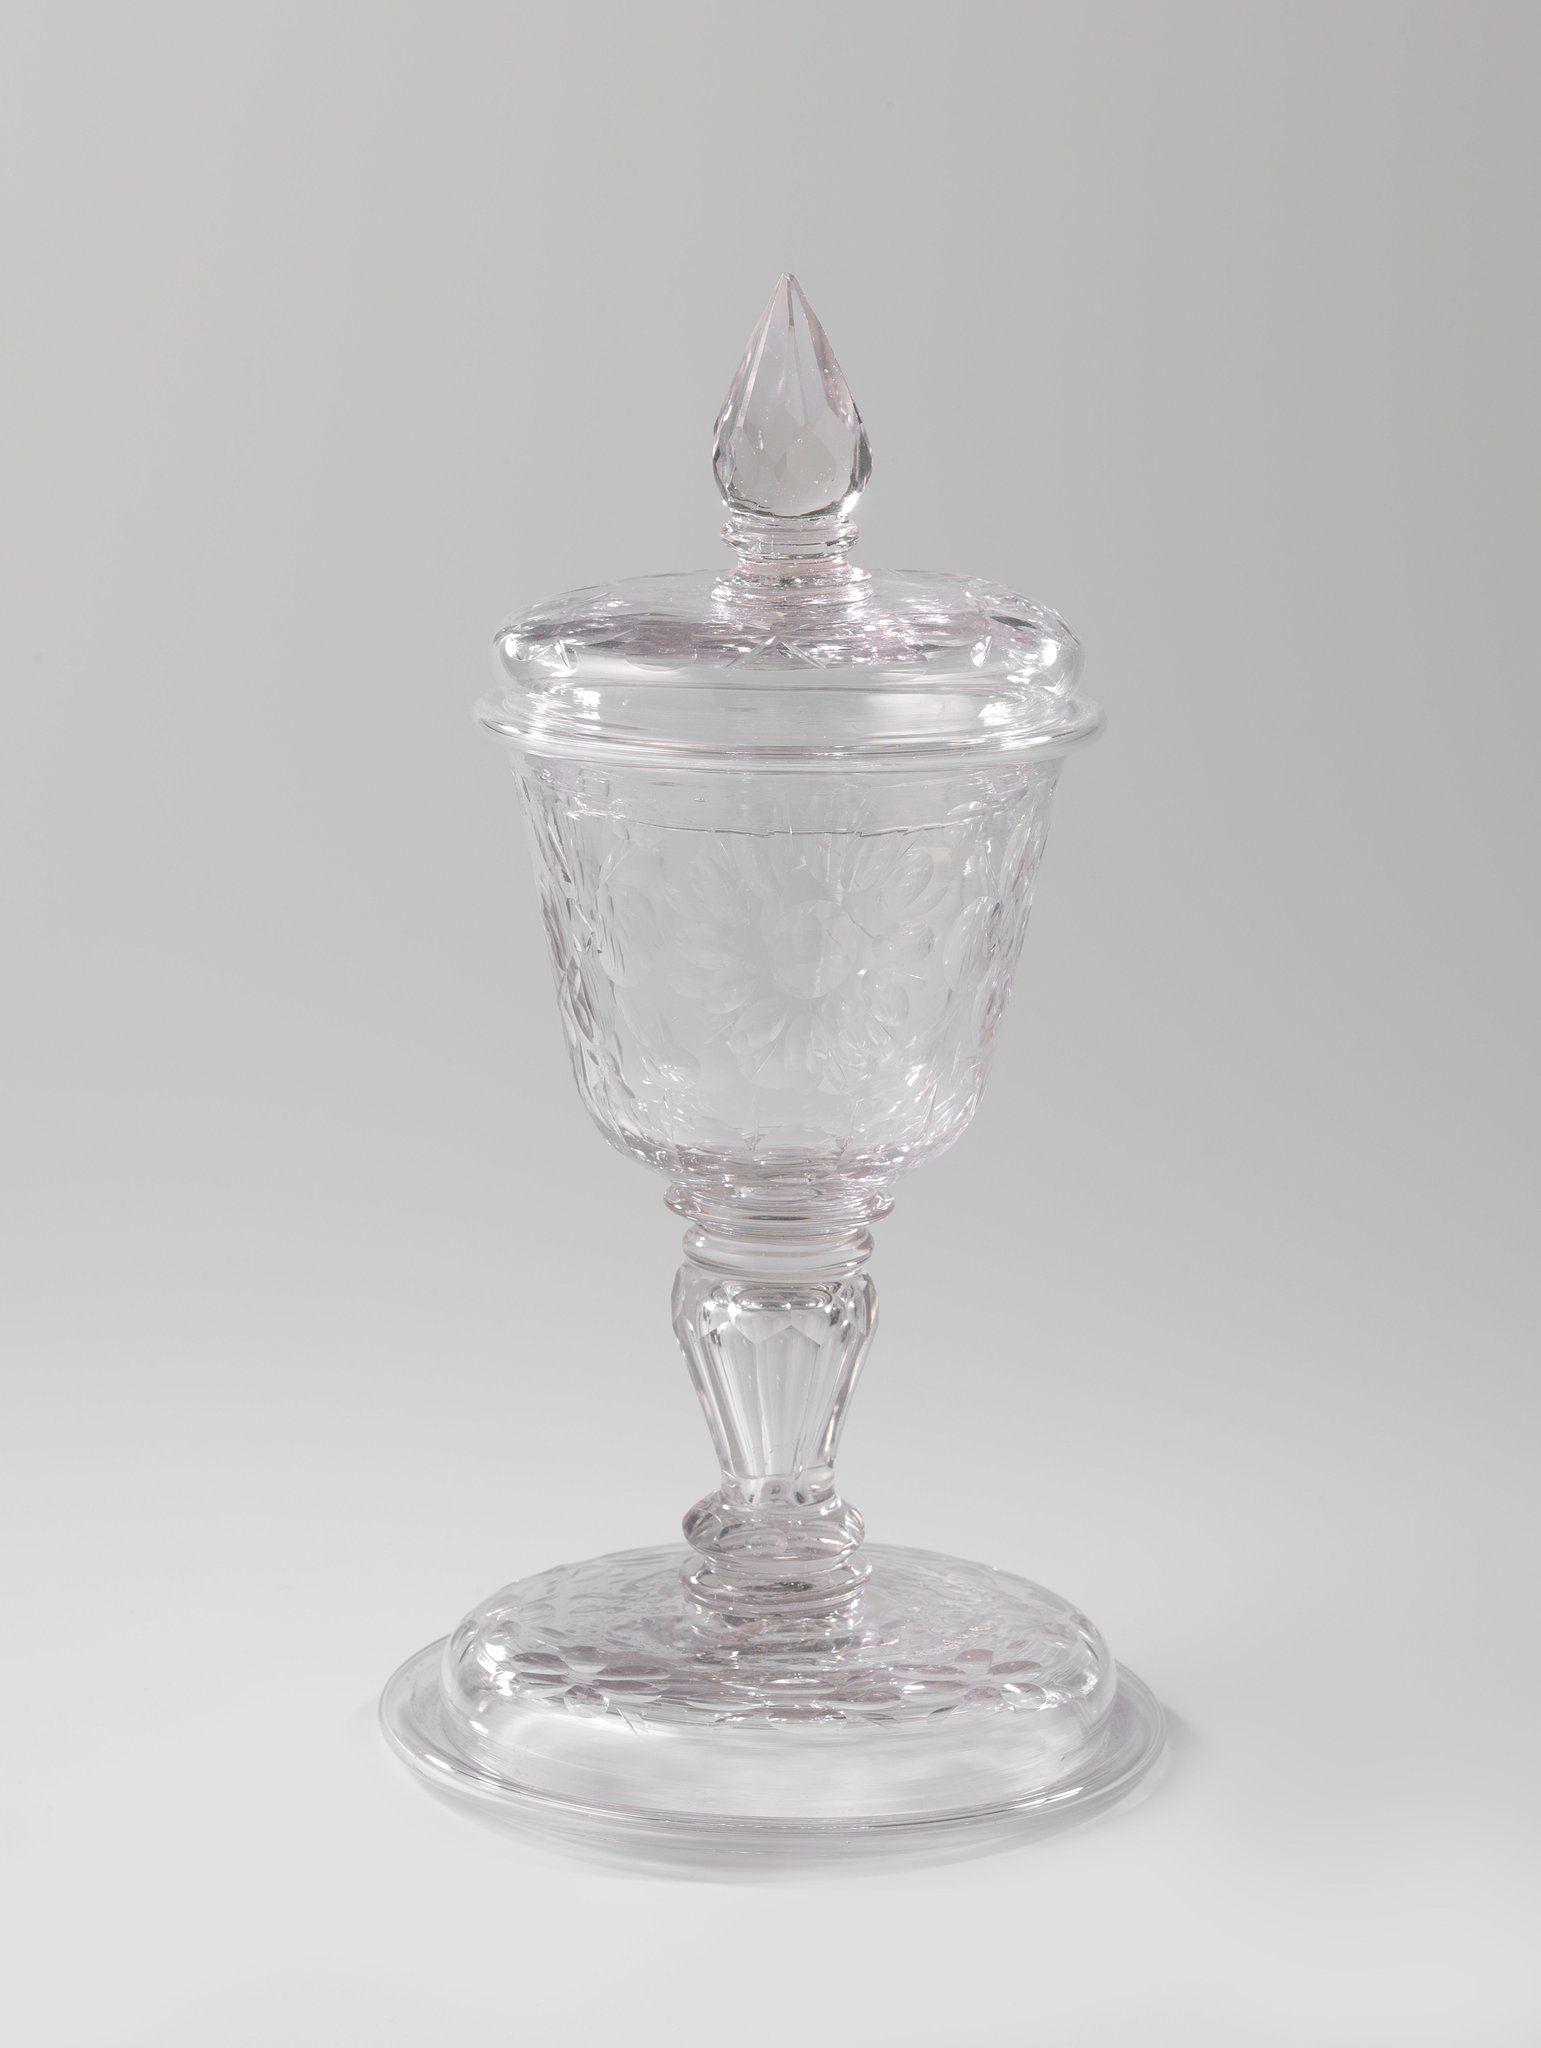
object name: dubbelbokaal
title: Bokaal met deksel, staande op een voet welke gediend heeft als deksel van een grotere bokaal (bovenstuk van een dubbelbokaal)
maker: Anonymous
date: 1800-1900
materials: glass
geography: bohemia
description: Bokaal met deksel, staande op een voet welke gediend heeft als deksel van een grotere bokaal (bovenstuk van een dubbelbokaal)